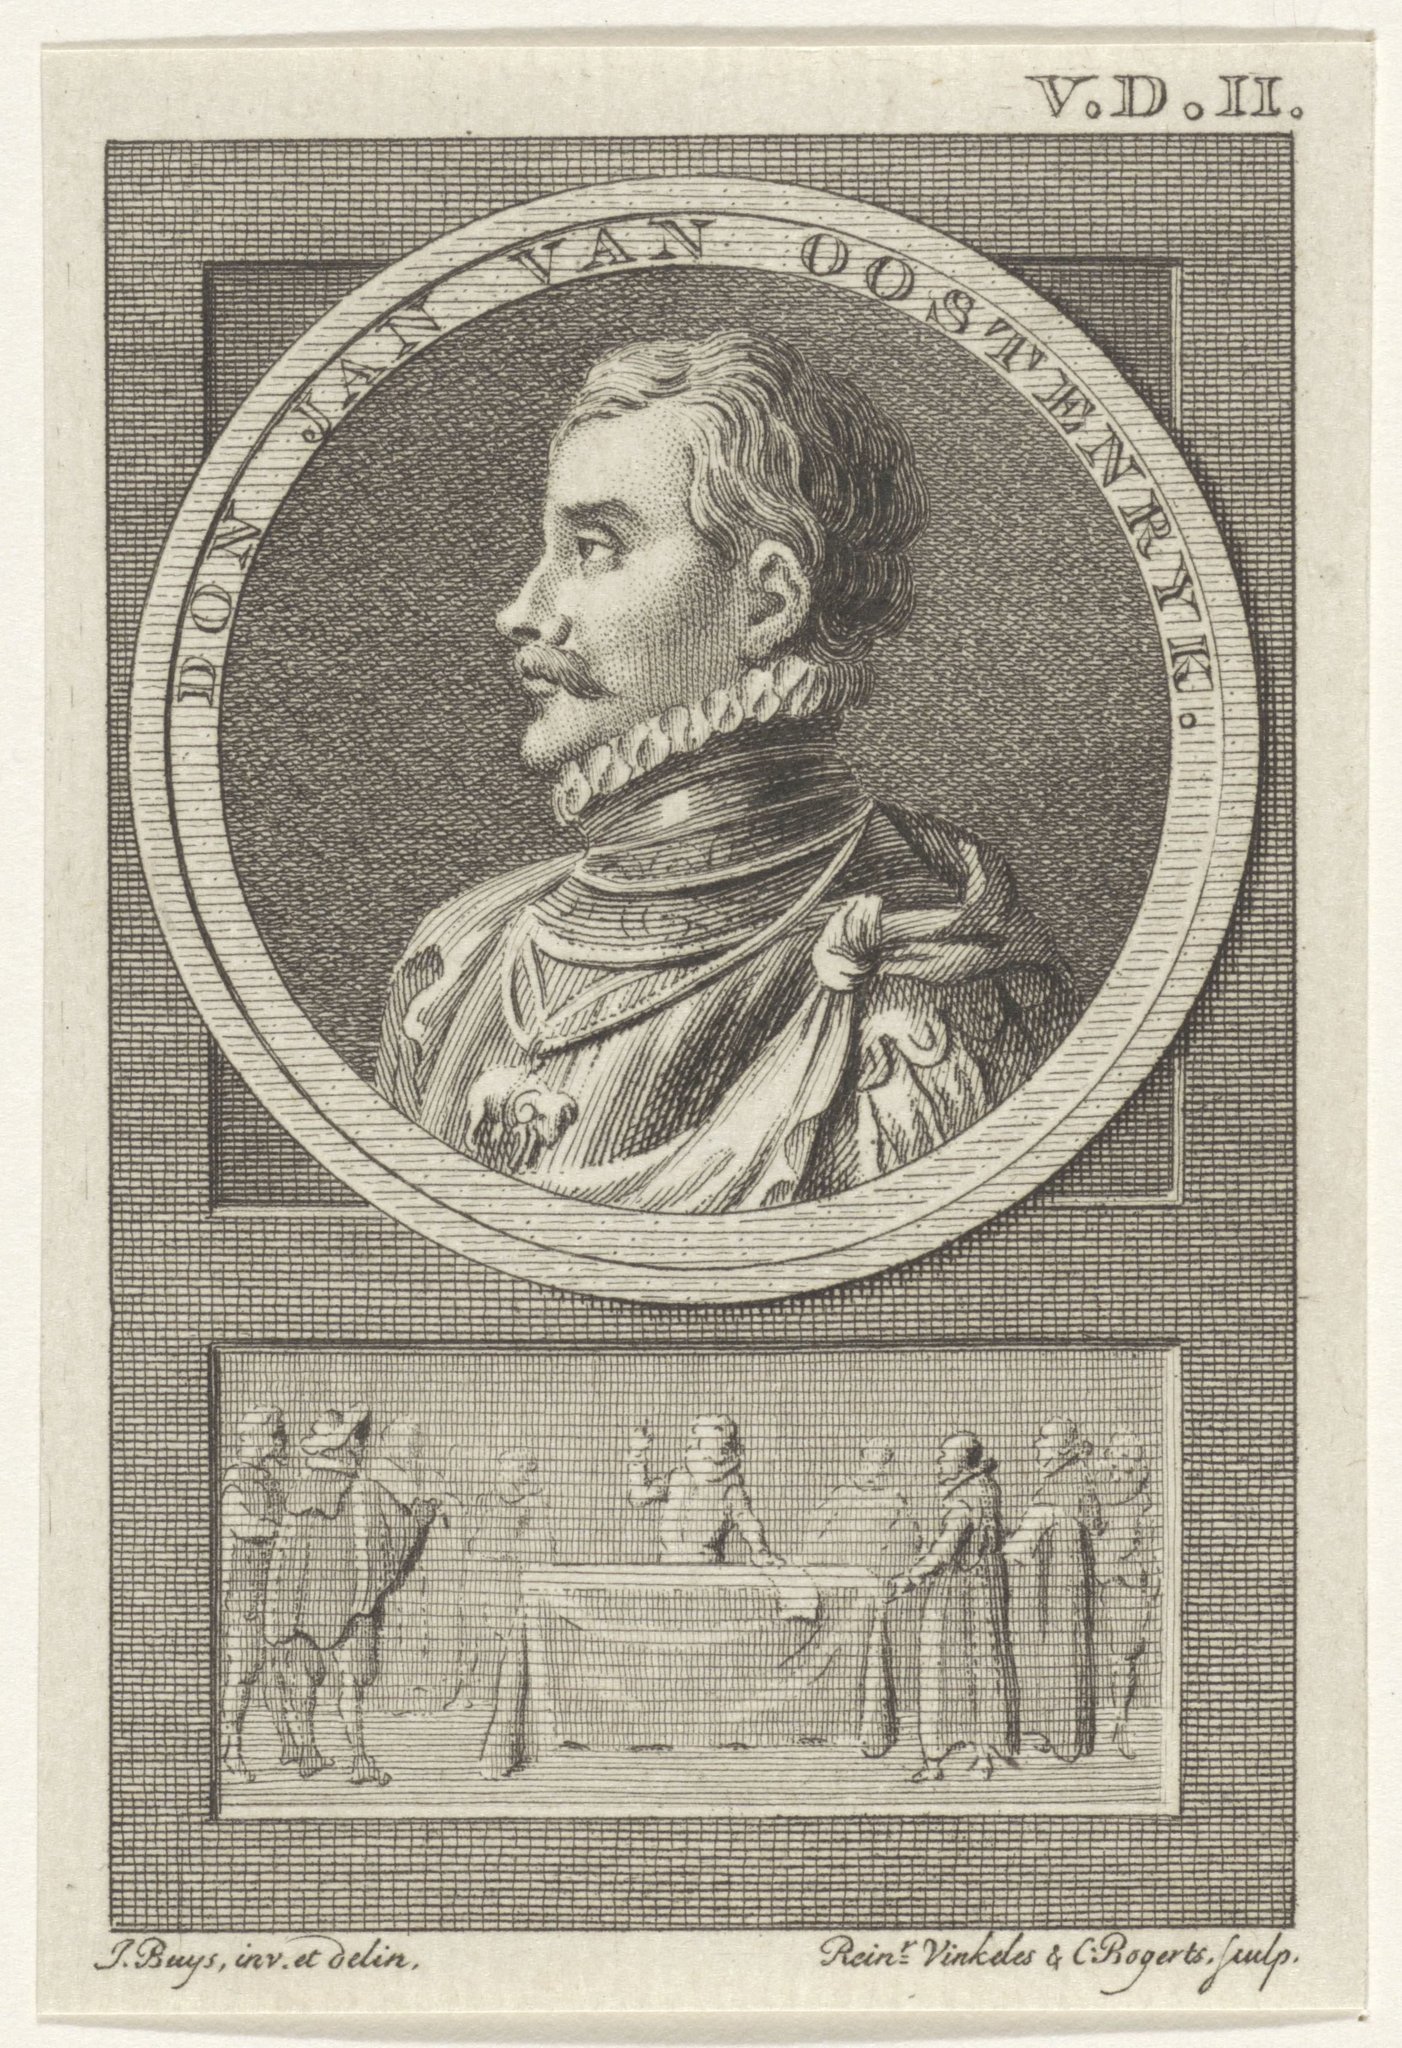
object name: print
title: Portret van Jan van Oostenrijk, landvoogd der Nederlanden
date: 1783-1795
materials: paper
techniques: engraving, etching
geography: amsterdam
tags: don juan van oostenrijk, meeting, assembly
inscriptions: collector's mark: Lugt 2228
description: Prent gebruikt in: Fokke, Jan. Geschiedenissen der Vereenigde Nederlanden voor de vaderlandsche jeugd Ie-XXVste deel. Amsterdam: Johannes Allart, 1783-1795. Deel V.